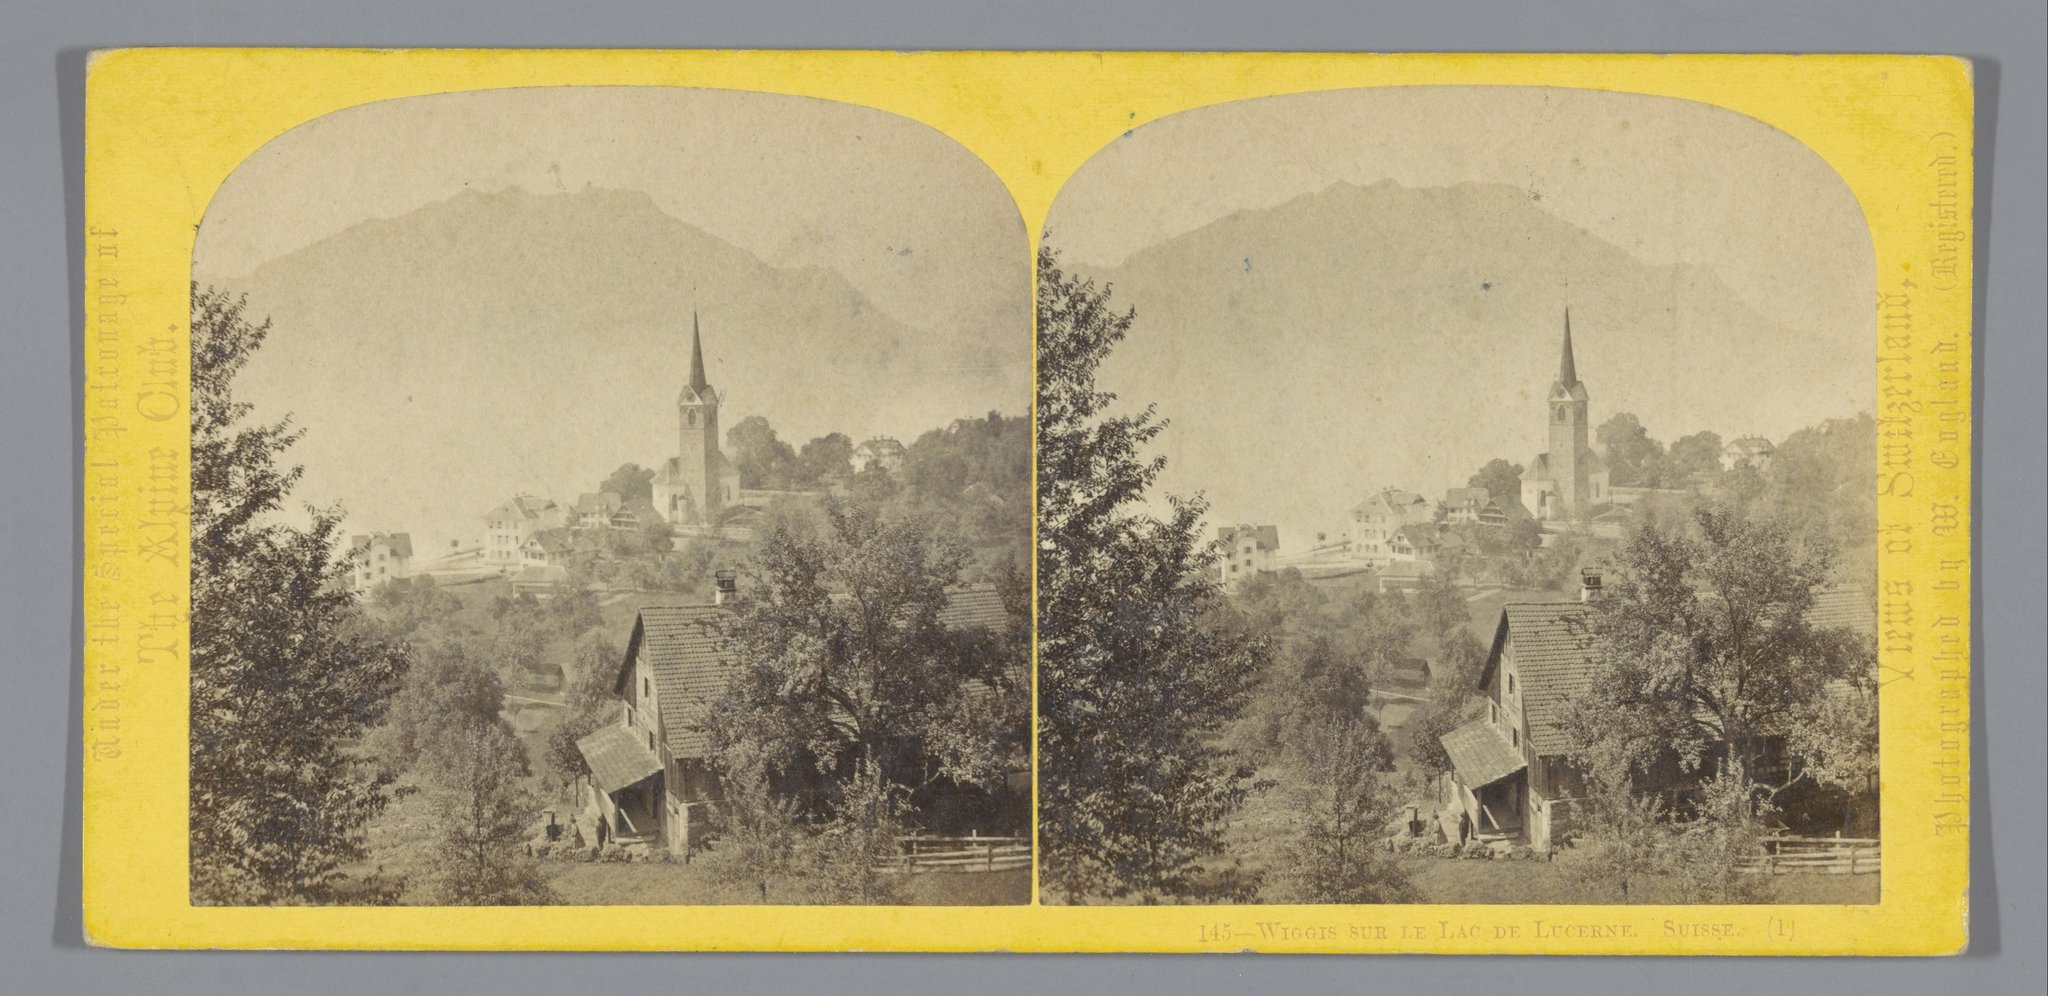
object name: stereograph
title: Wiggis sur le Lac de Lucerne. Suisse. (1)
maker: william england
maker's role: fotograaf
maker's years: 1816-1896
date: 1850-1880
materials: cardboard, photographic support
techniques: albumen print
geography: weggis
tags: city-view in general; 'veduta'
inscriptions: number: ‘46’, inscription: ‘Views of Switzerland, photographed by W. England. (Registered) Under the Special Patronage of the Alpine Club.’, number: ‘145.’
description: Het object RP-F-F08094 is vermoedelijk tijdens dezelfde fotografeersessie gemaakt.